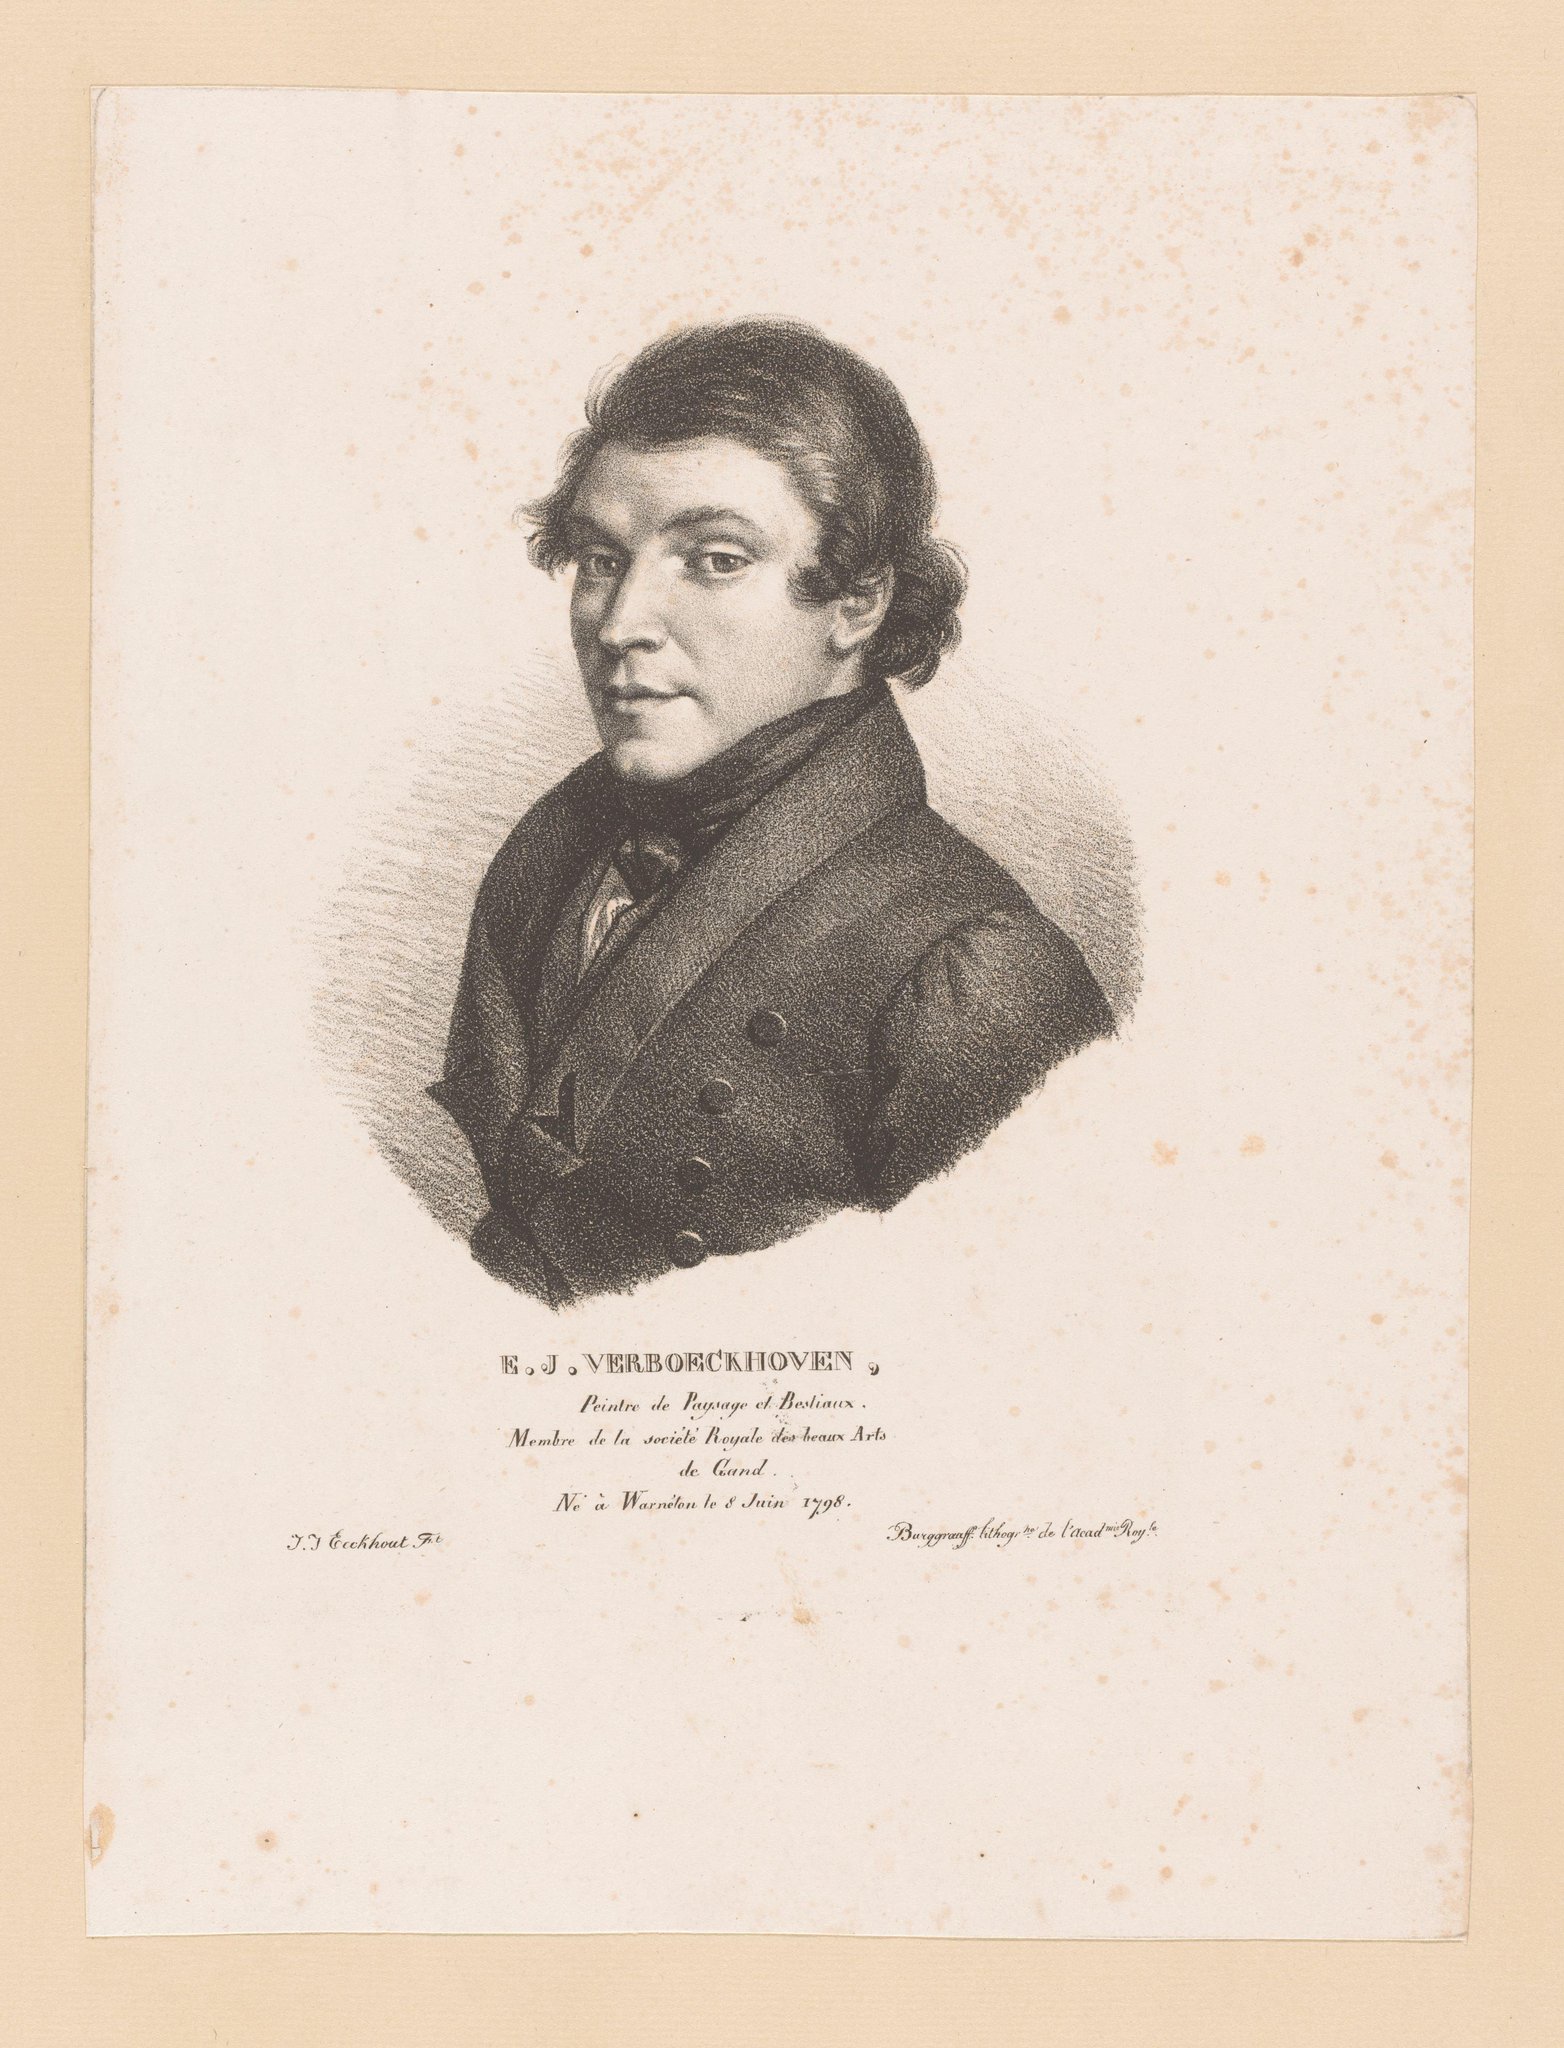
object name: print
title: E.J. Verboeckhoven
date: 1822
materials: paper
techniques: lithograph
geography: brussels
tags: painter, print maker, draughtsman, printer, eugène verboeckhoven, historical persons, portrait, self-portrait of painter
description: Prent maakt deel uit van een serie van zestig prenten.